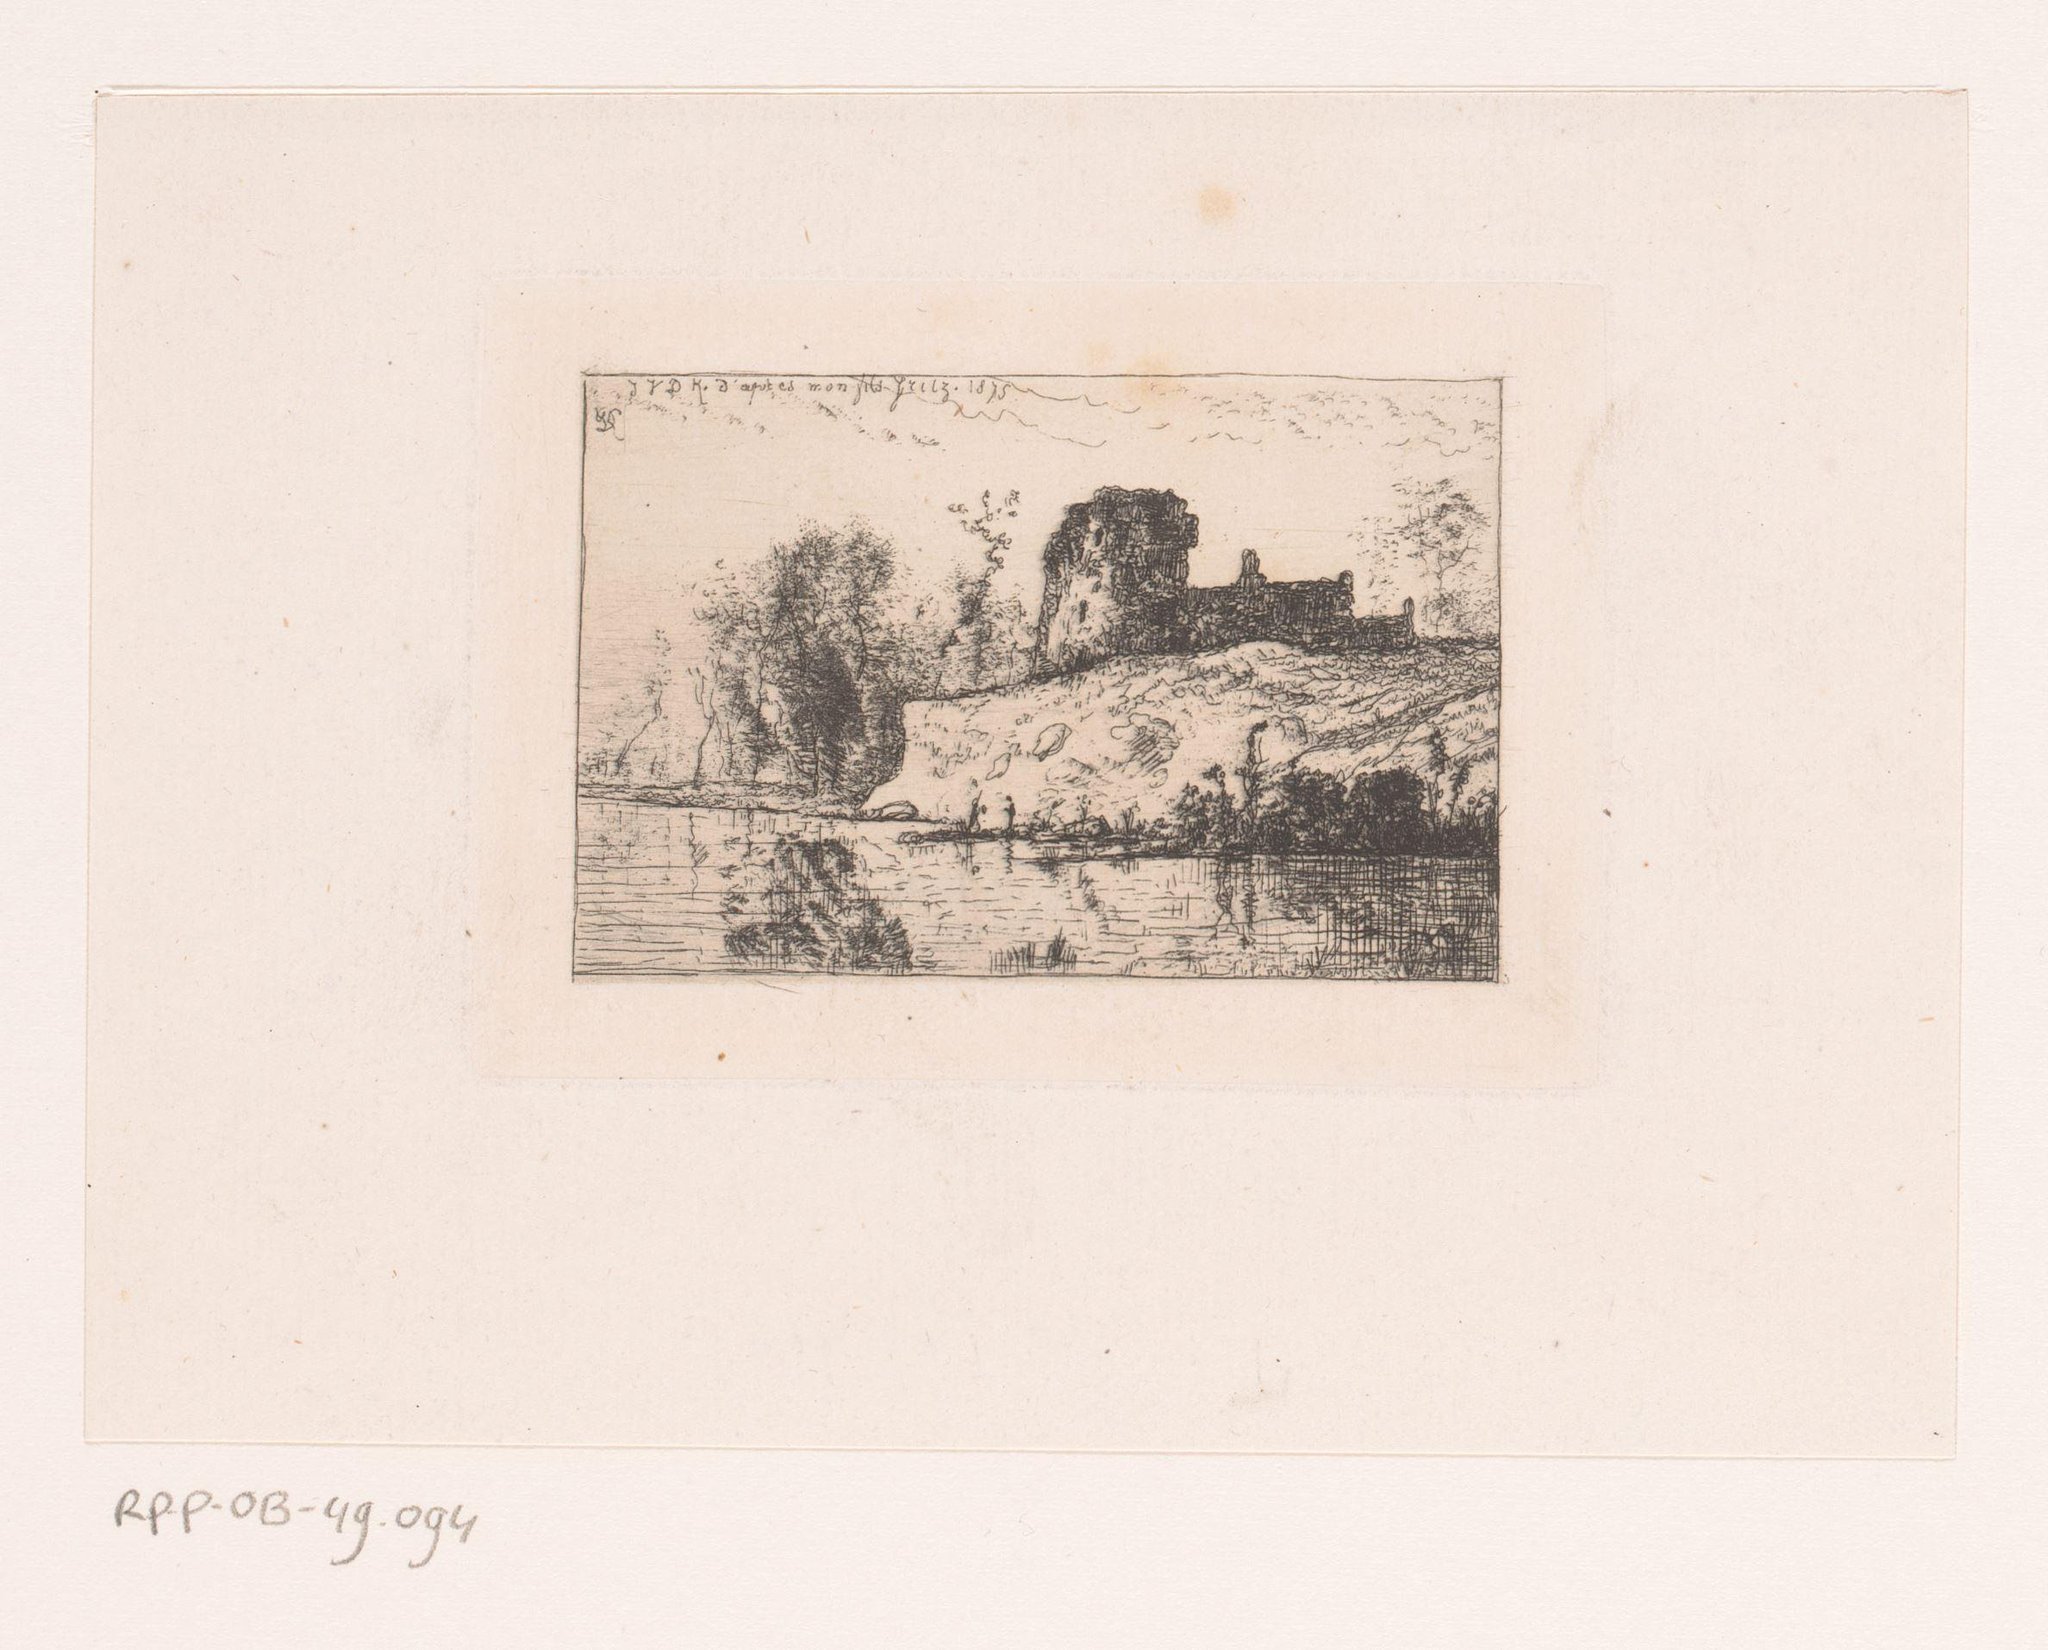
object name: print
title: Ruïne op een heuvel aan het water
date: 1875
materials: paper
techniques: drypoint, etching, intaglio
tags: (high) hill, landscape with ruins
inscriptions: collector's mark: Lugt 2228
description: De etsen naar de schilderijen van Frédéric Van de Kerkhove werden na zijn dood door zijn vader en zuster gemaakt en uitgegeven in twee reeksen. De eerste werd in 1877 uitgegeven door het Journal des Beaux-Arts et de la Littérature: Cahier de 25 Eaux-fortes d'après Frédéric van de Kerkhove, gravées par son père et sa sœur. De tweede reeks van 126 etsen, ook in 1877, werd in Parijs uitgegeven bij A. Lévy onder de titel Cent eaux-fortes gravées par J. Van de Kerkhove d'après les tableaux de Frédéric Van de Kerkhove, mort en 1873 à l'âge de 10 ans et 11 mois.